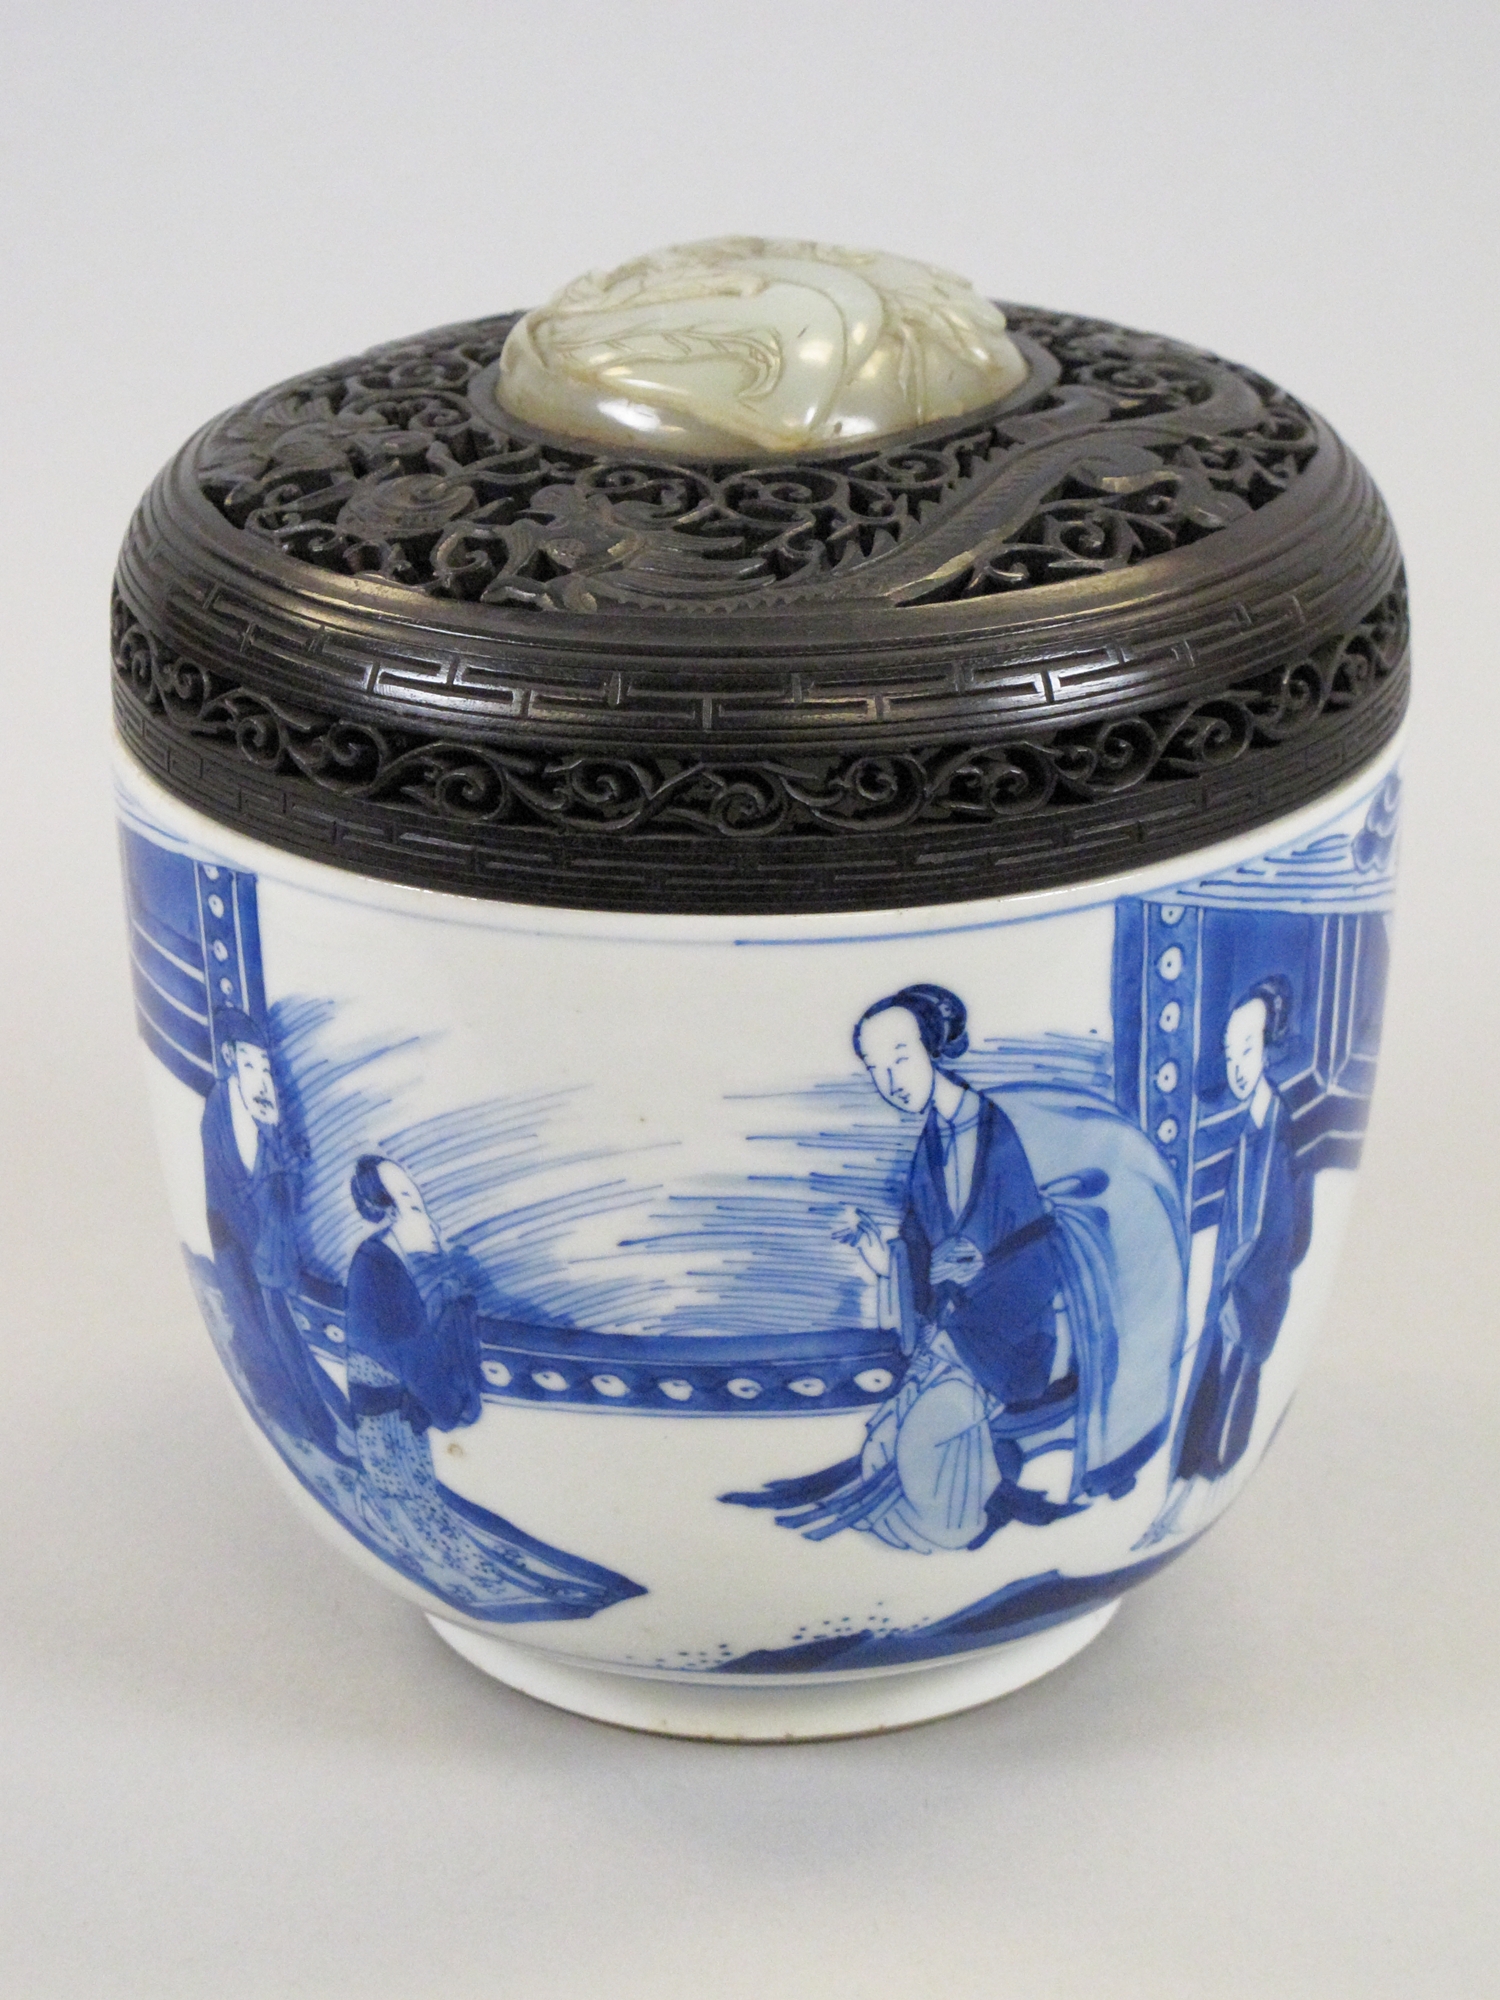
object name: jar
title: Jar with theatrical scene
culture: chinese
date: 1668-1722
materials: cobalt, jade, porcelain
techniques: painting, underglaze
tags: men,women